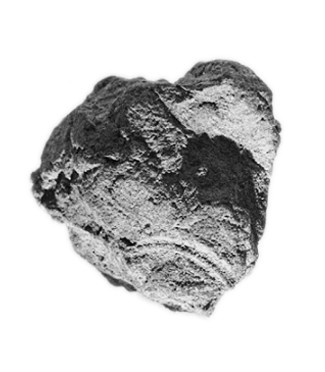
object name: sealing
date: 1981-1640 BCE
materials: mud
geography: egypt